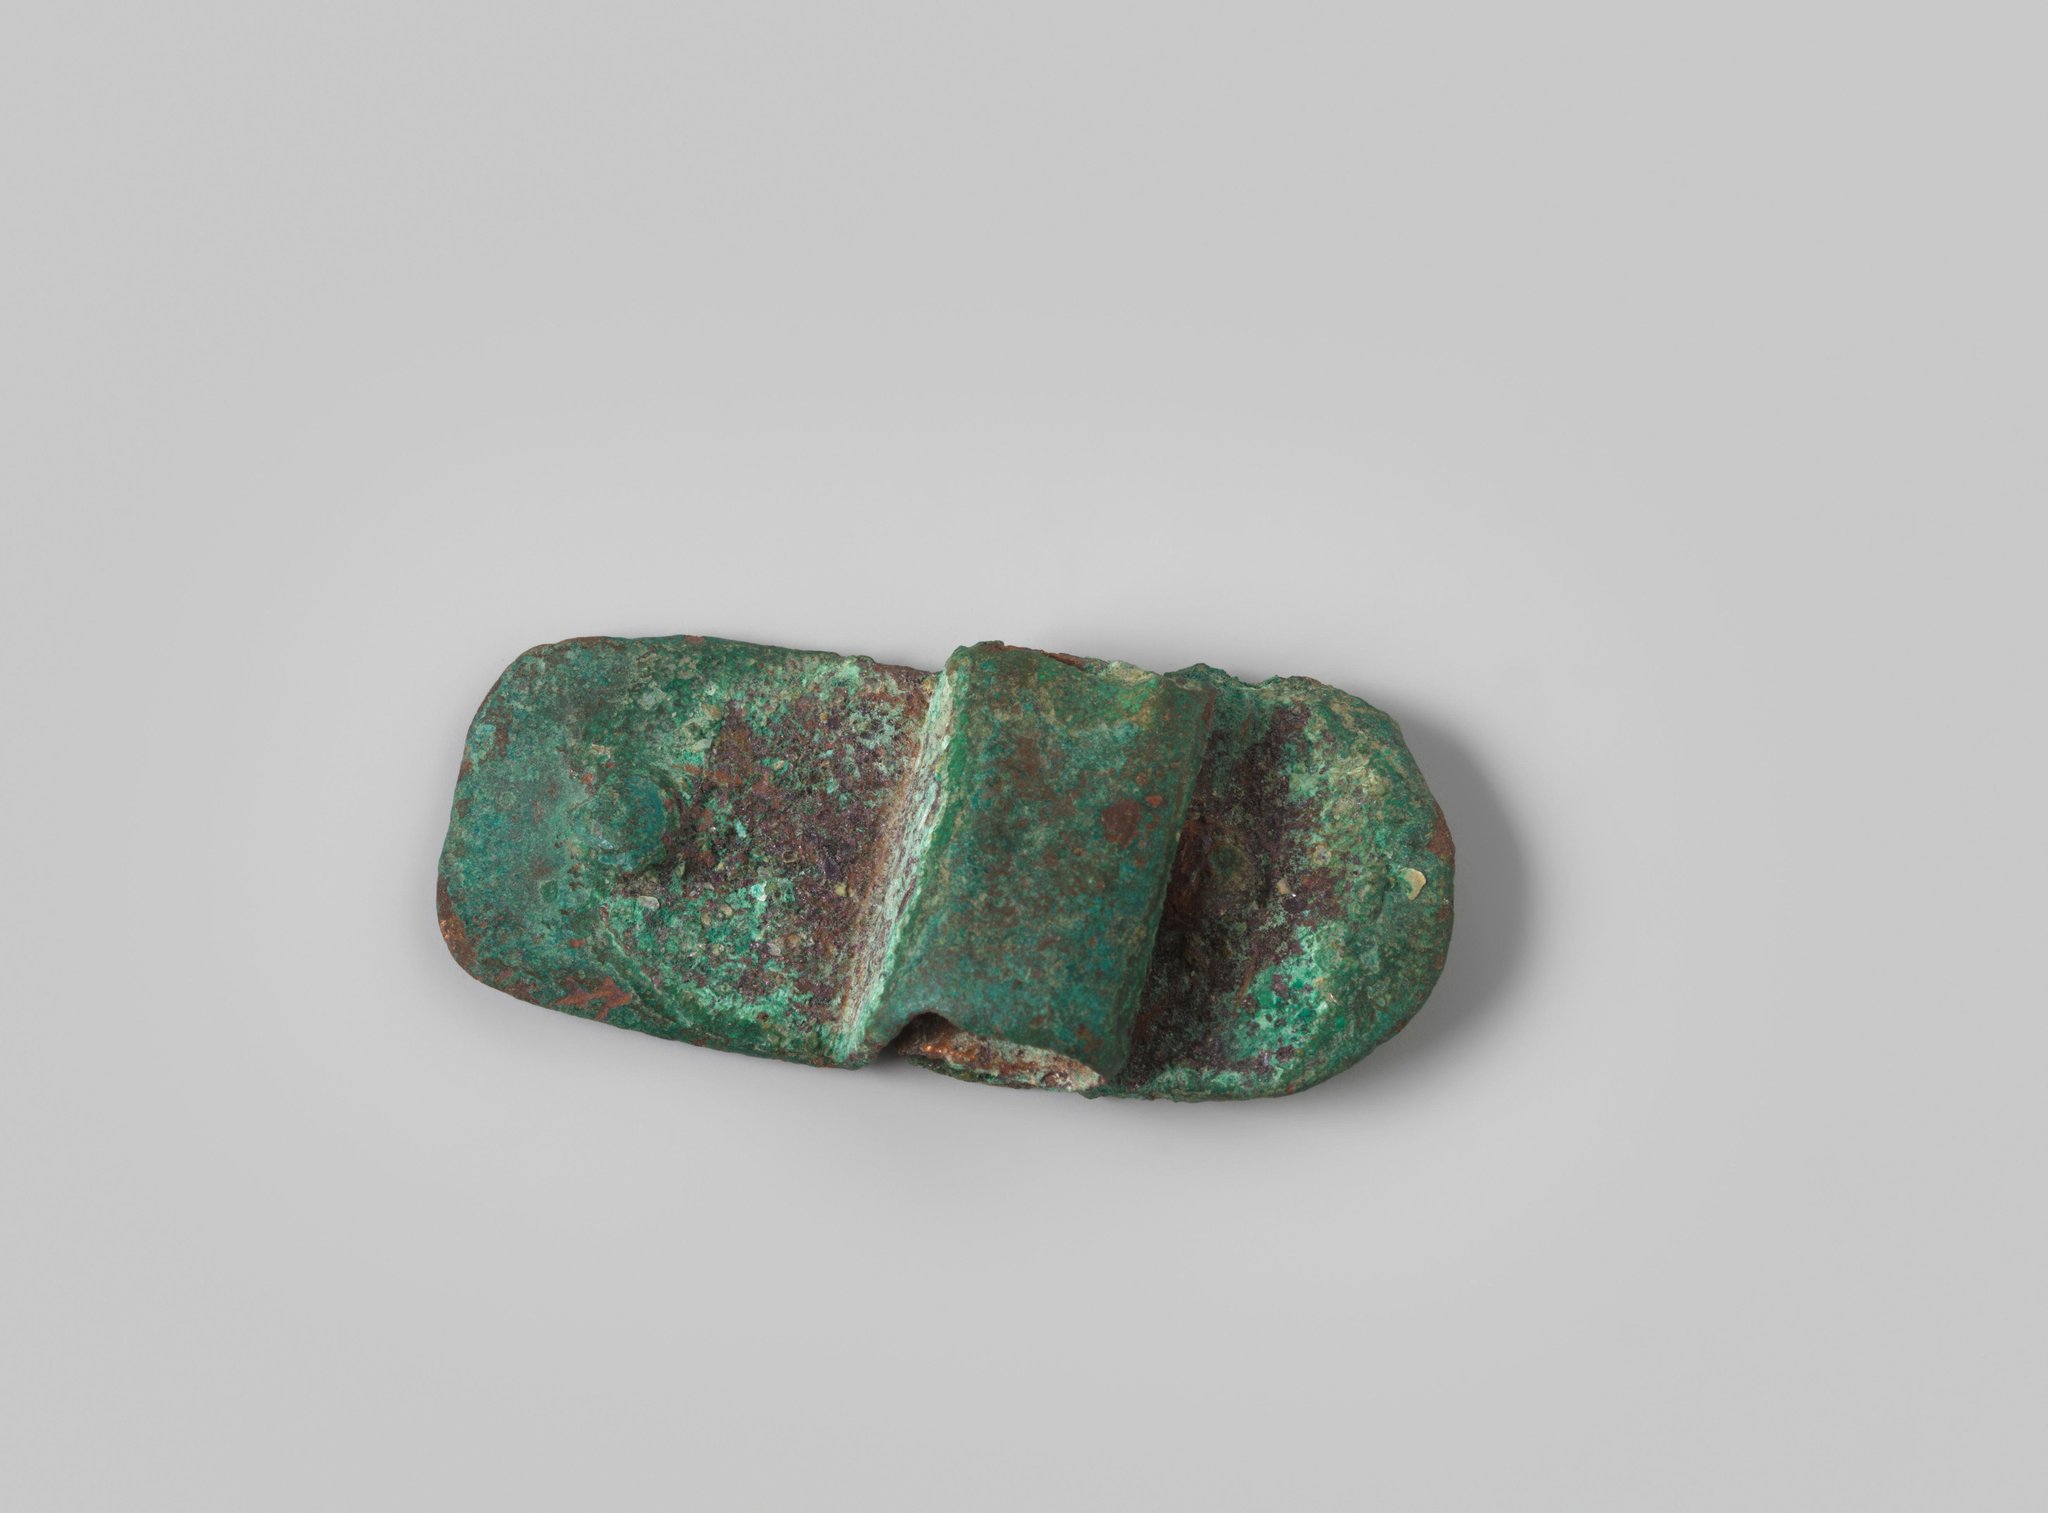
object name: cartridge canister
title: Oor van een kardoeskoker uit het wrak van de Oost-Indiëvaarder Hollandia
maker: Anonymous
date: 1700-1743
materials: copper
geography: netherlands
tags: verenigde oostindische compagnie, hollandia (schip), annet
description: Cartridge canister, lug; corroded, id. NG 1980-27H2394.